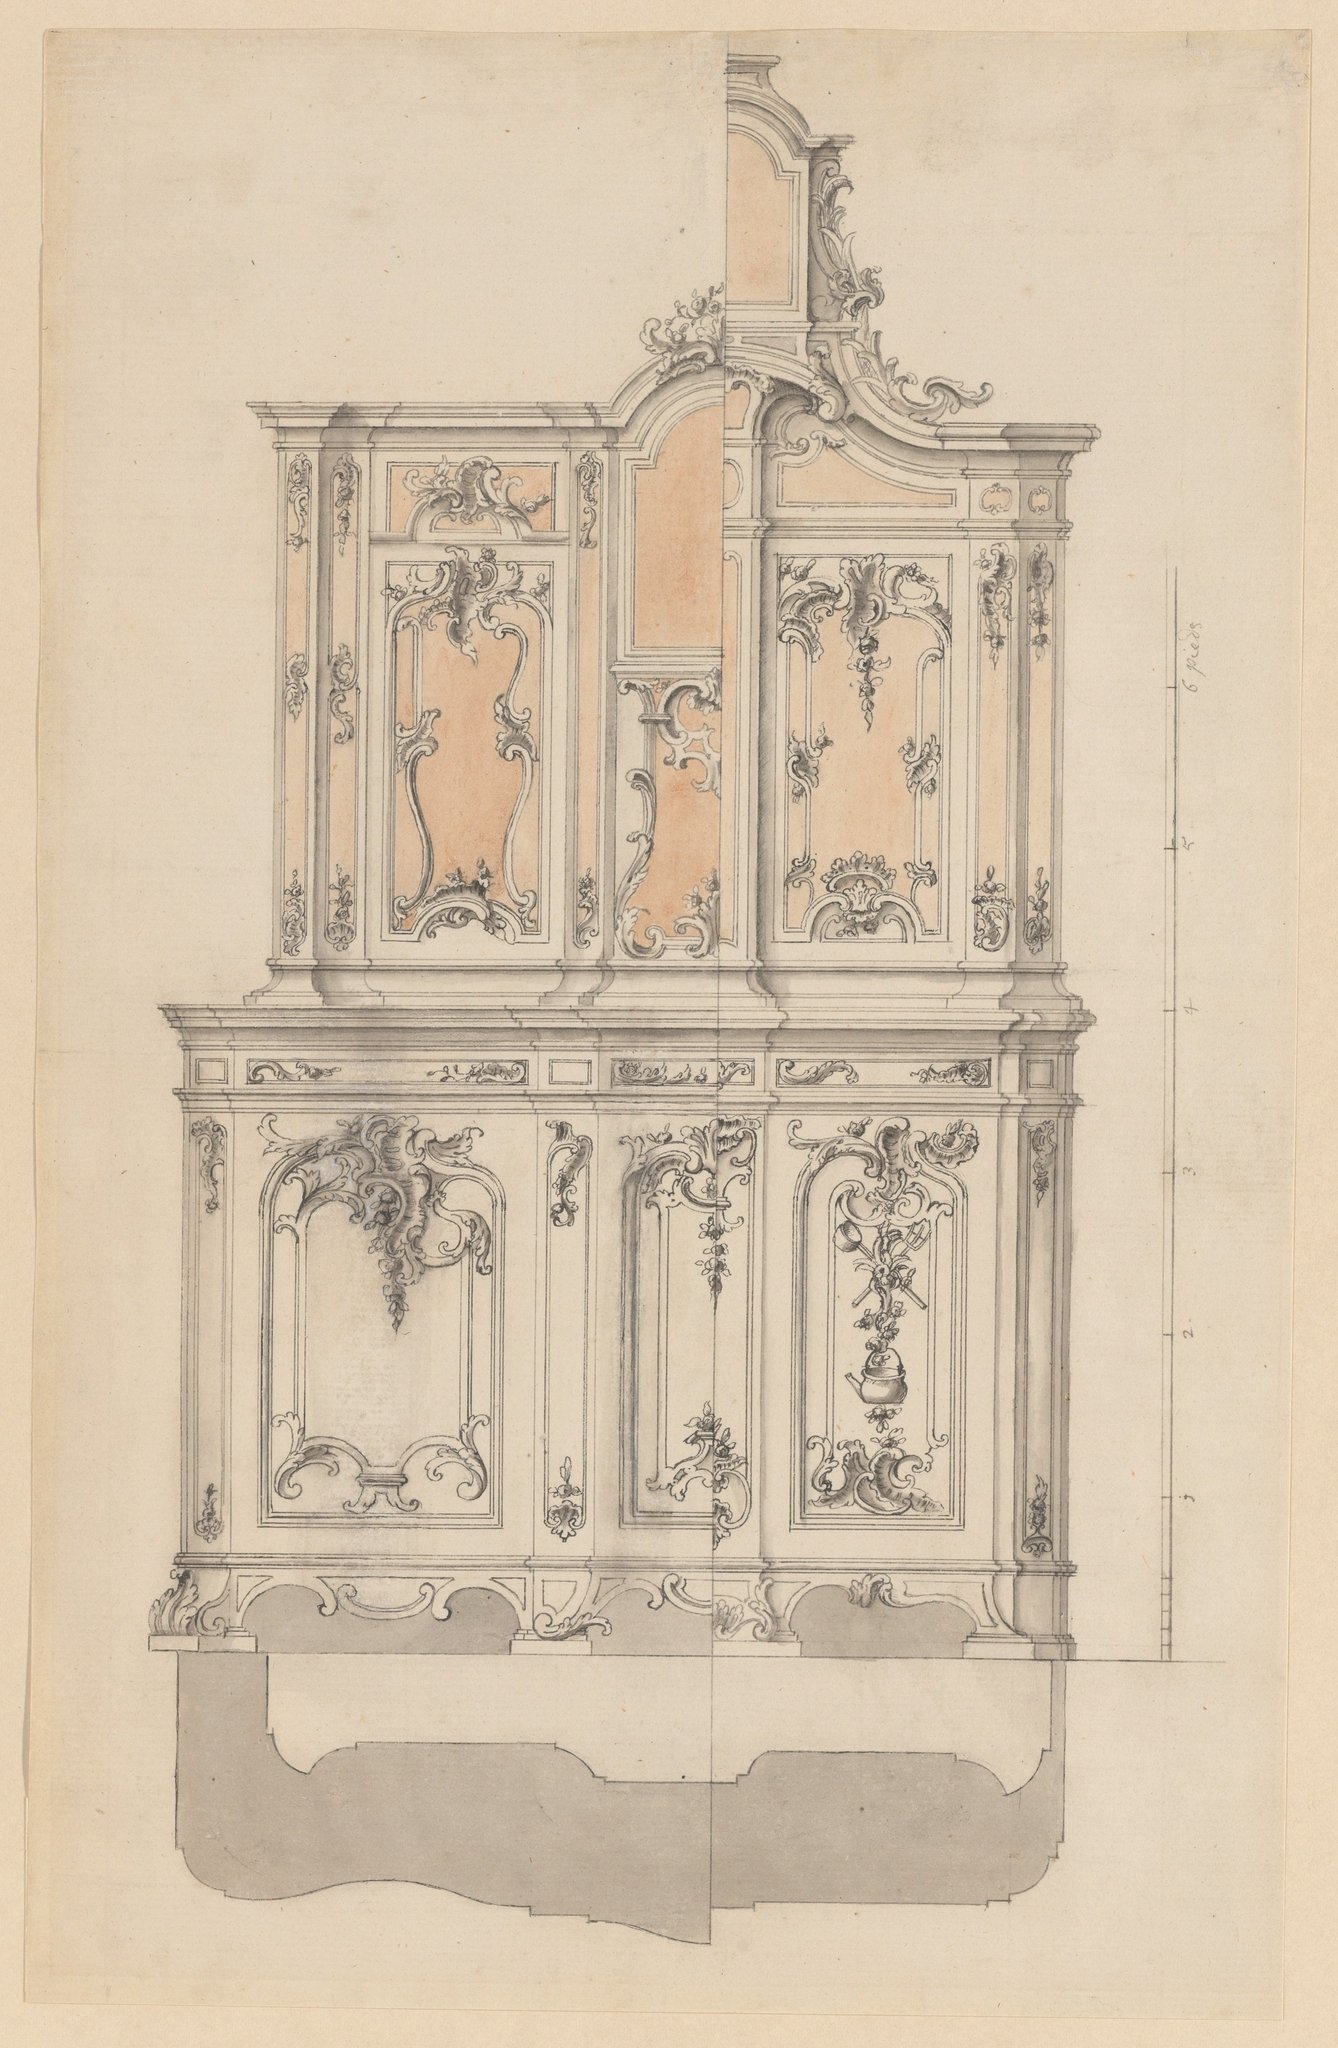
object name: drawing ornament architecture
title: Design for a Cabinet with an Alternative for the Right Side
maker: anonymous, french, 18th century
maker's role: artist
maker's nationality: french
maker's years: 1700-1800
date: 1730-1760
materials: ink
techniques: pen, wash